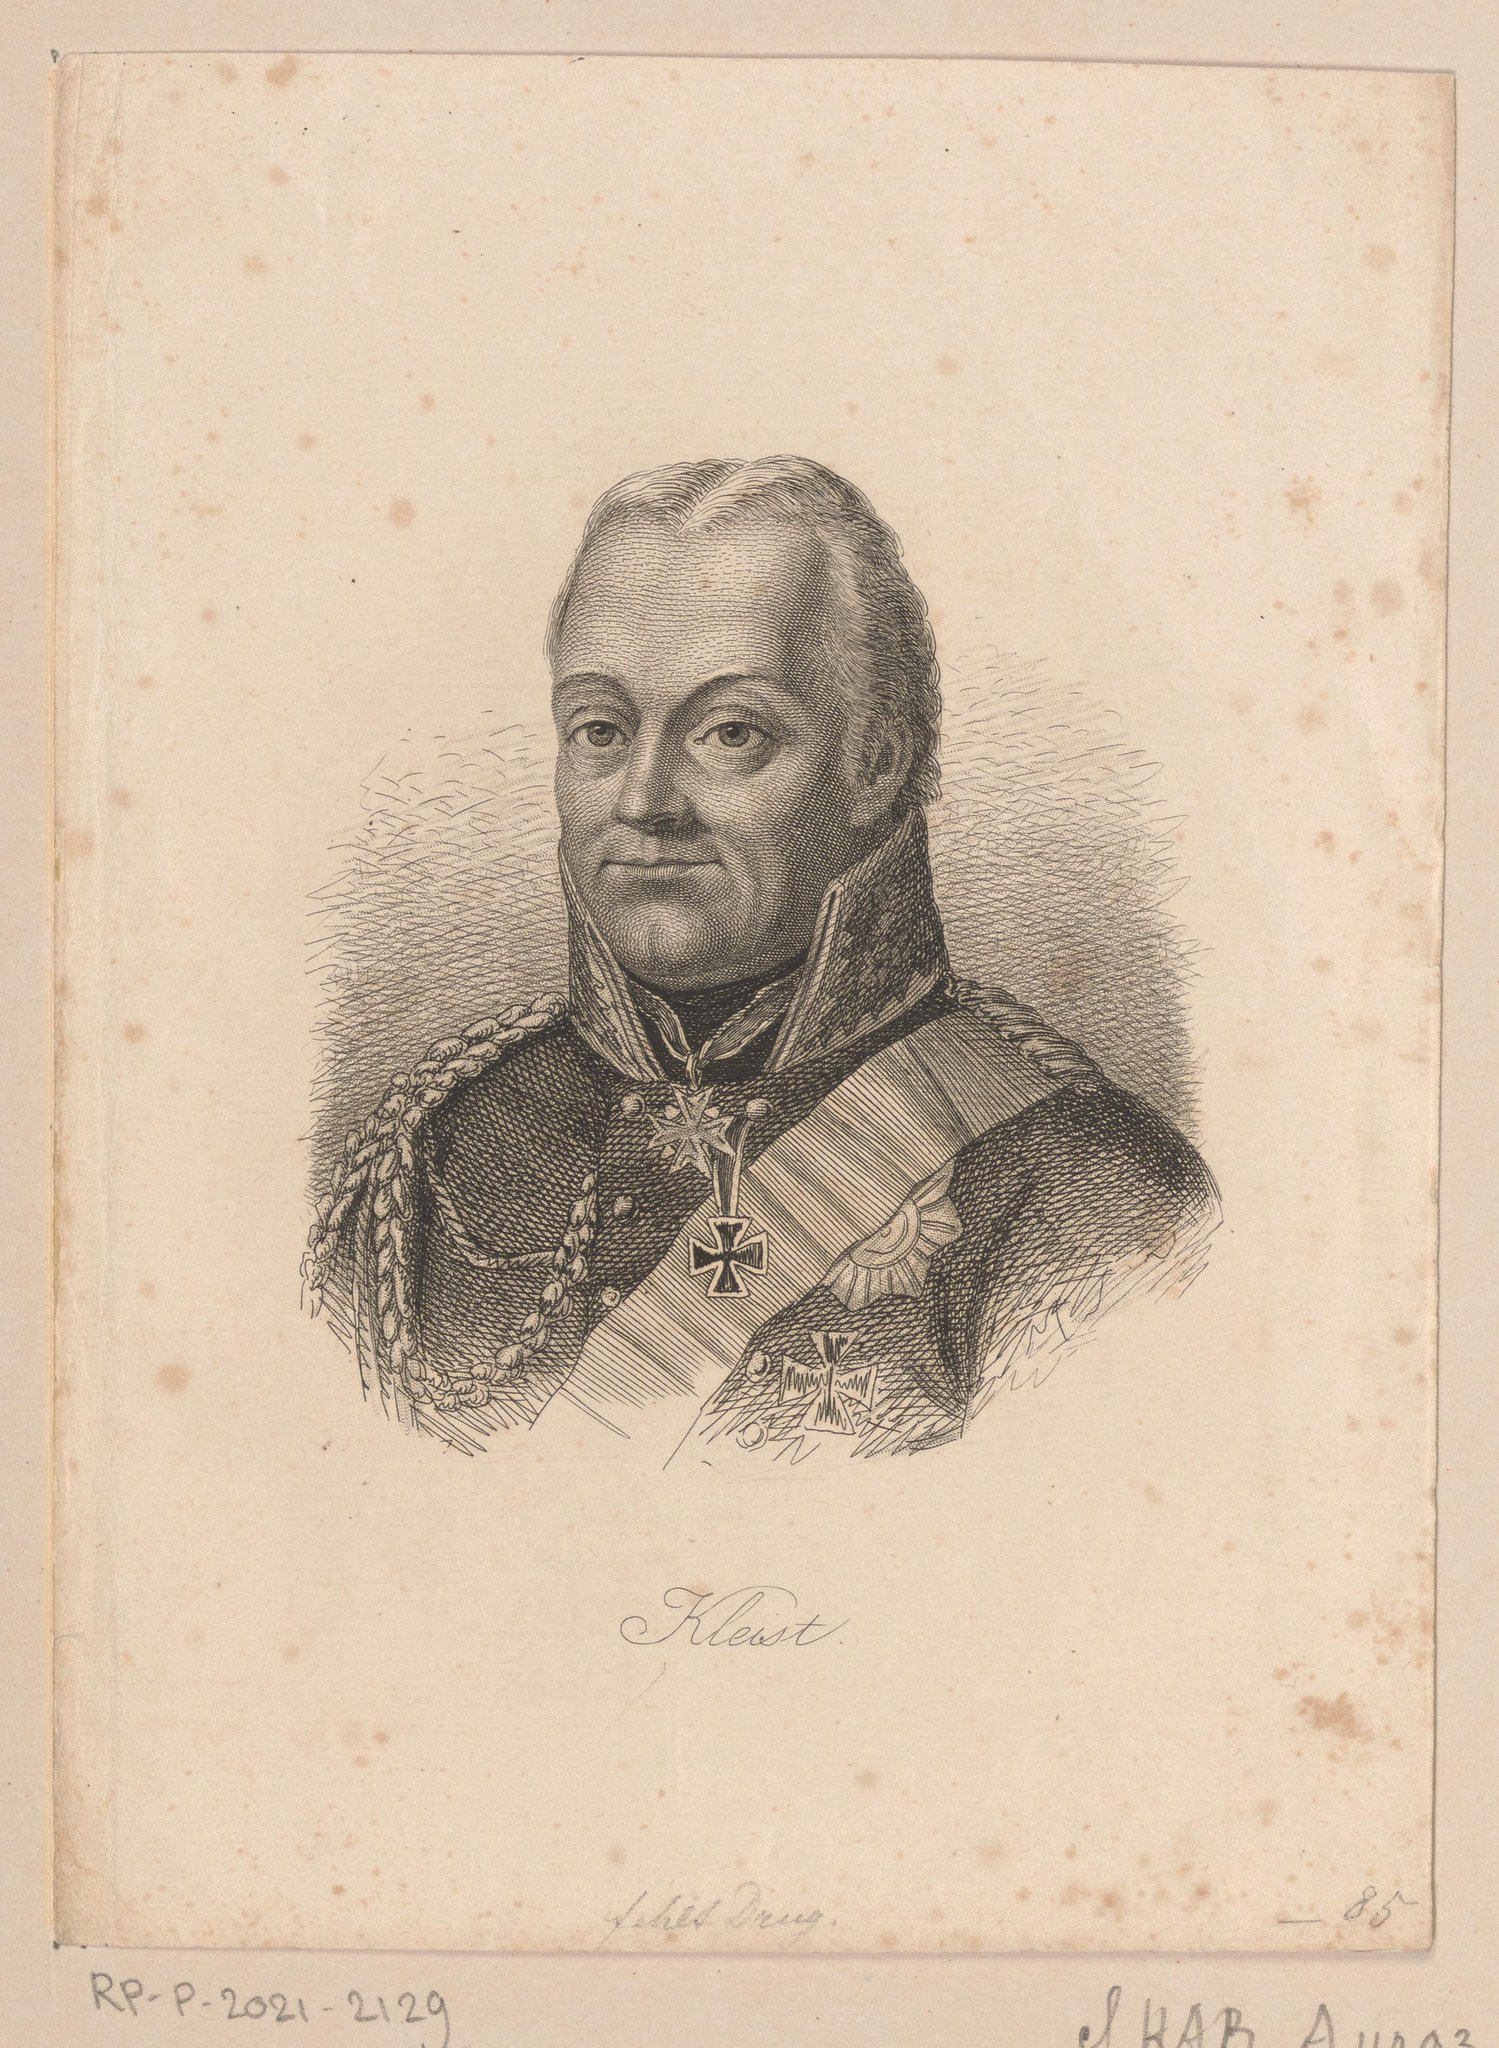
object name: print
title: Portret van Friedrich Heinrich Ferdinand Emil Kleist von Nollendorf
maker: Anonymous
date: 1792-1823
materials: paper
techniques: etching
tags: berlin, historical persons, medals and other marks of military honour